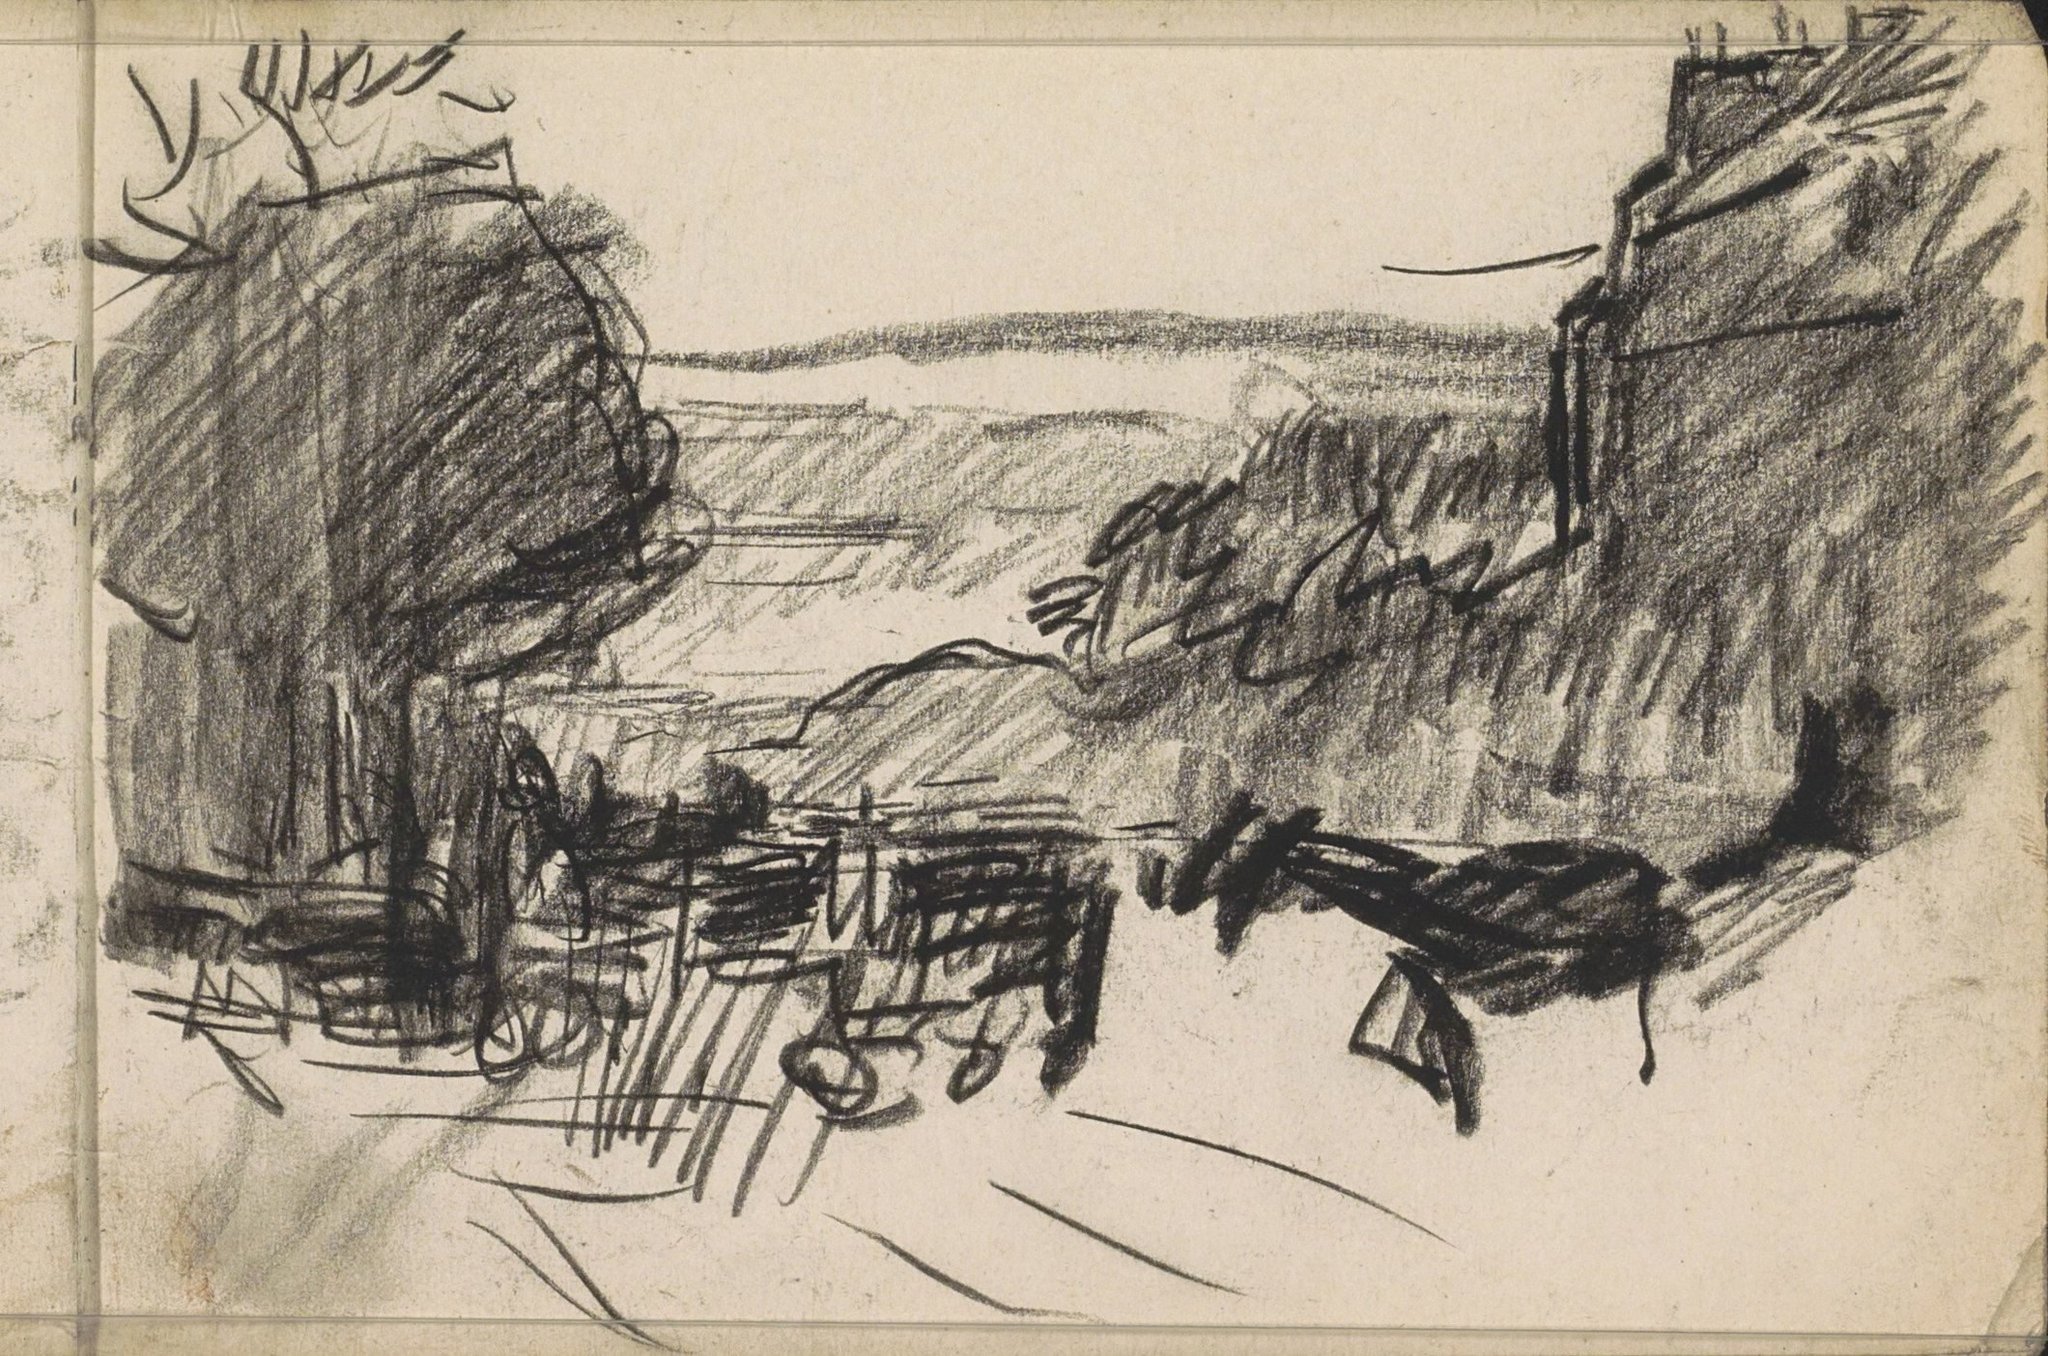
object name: sketchbook leaf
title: Rijtuigen op straat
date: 1875-1934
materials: chalk, paper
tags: four-wheeled, animal-drawn vehicle, e.g.: cab, carriage, coach, street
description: Pagina 23 uit schetsboek XLVI met 32 pagina's.